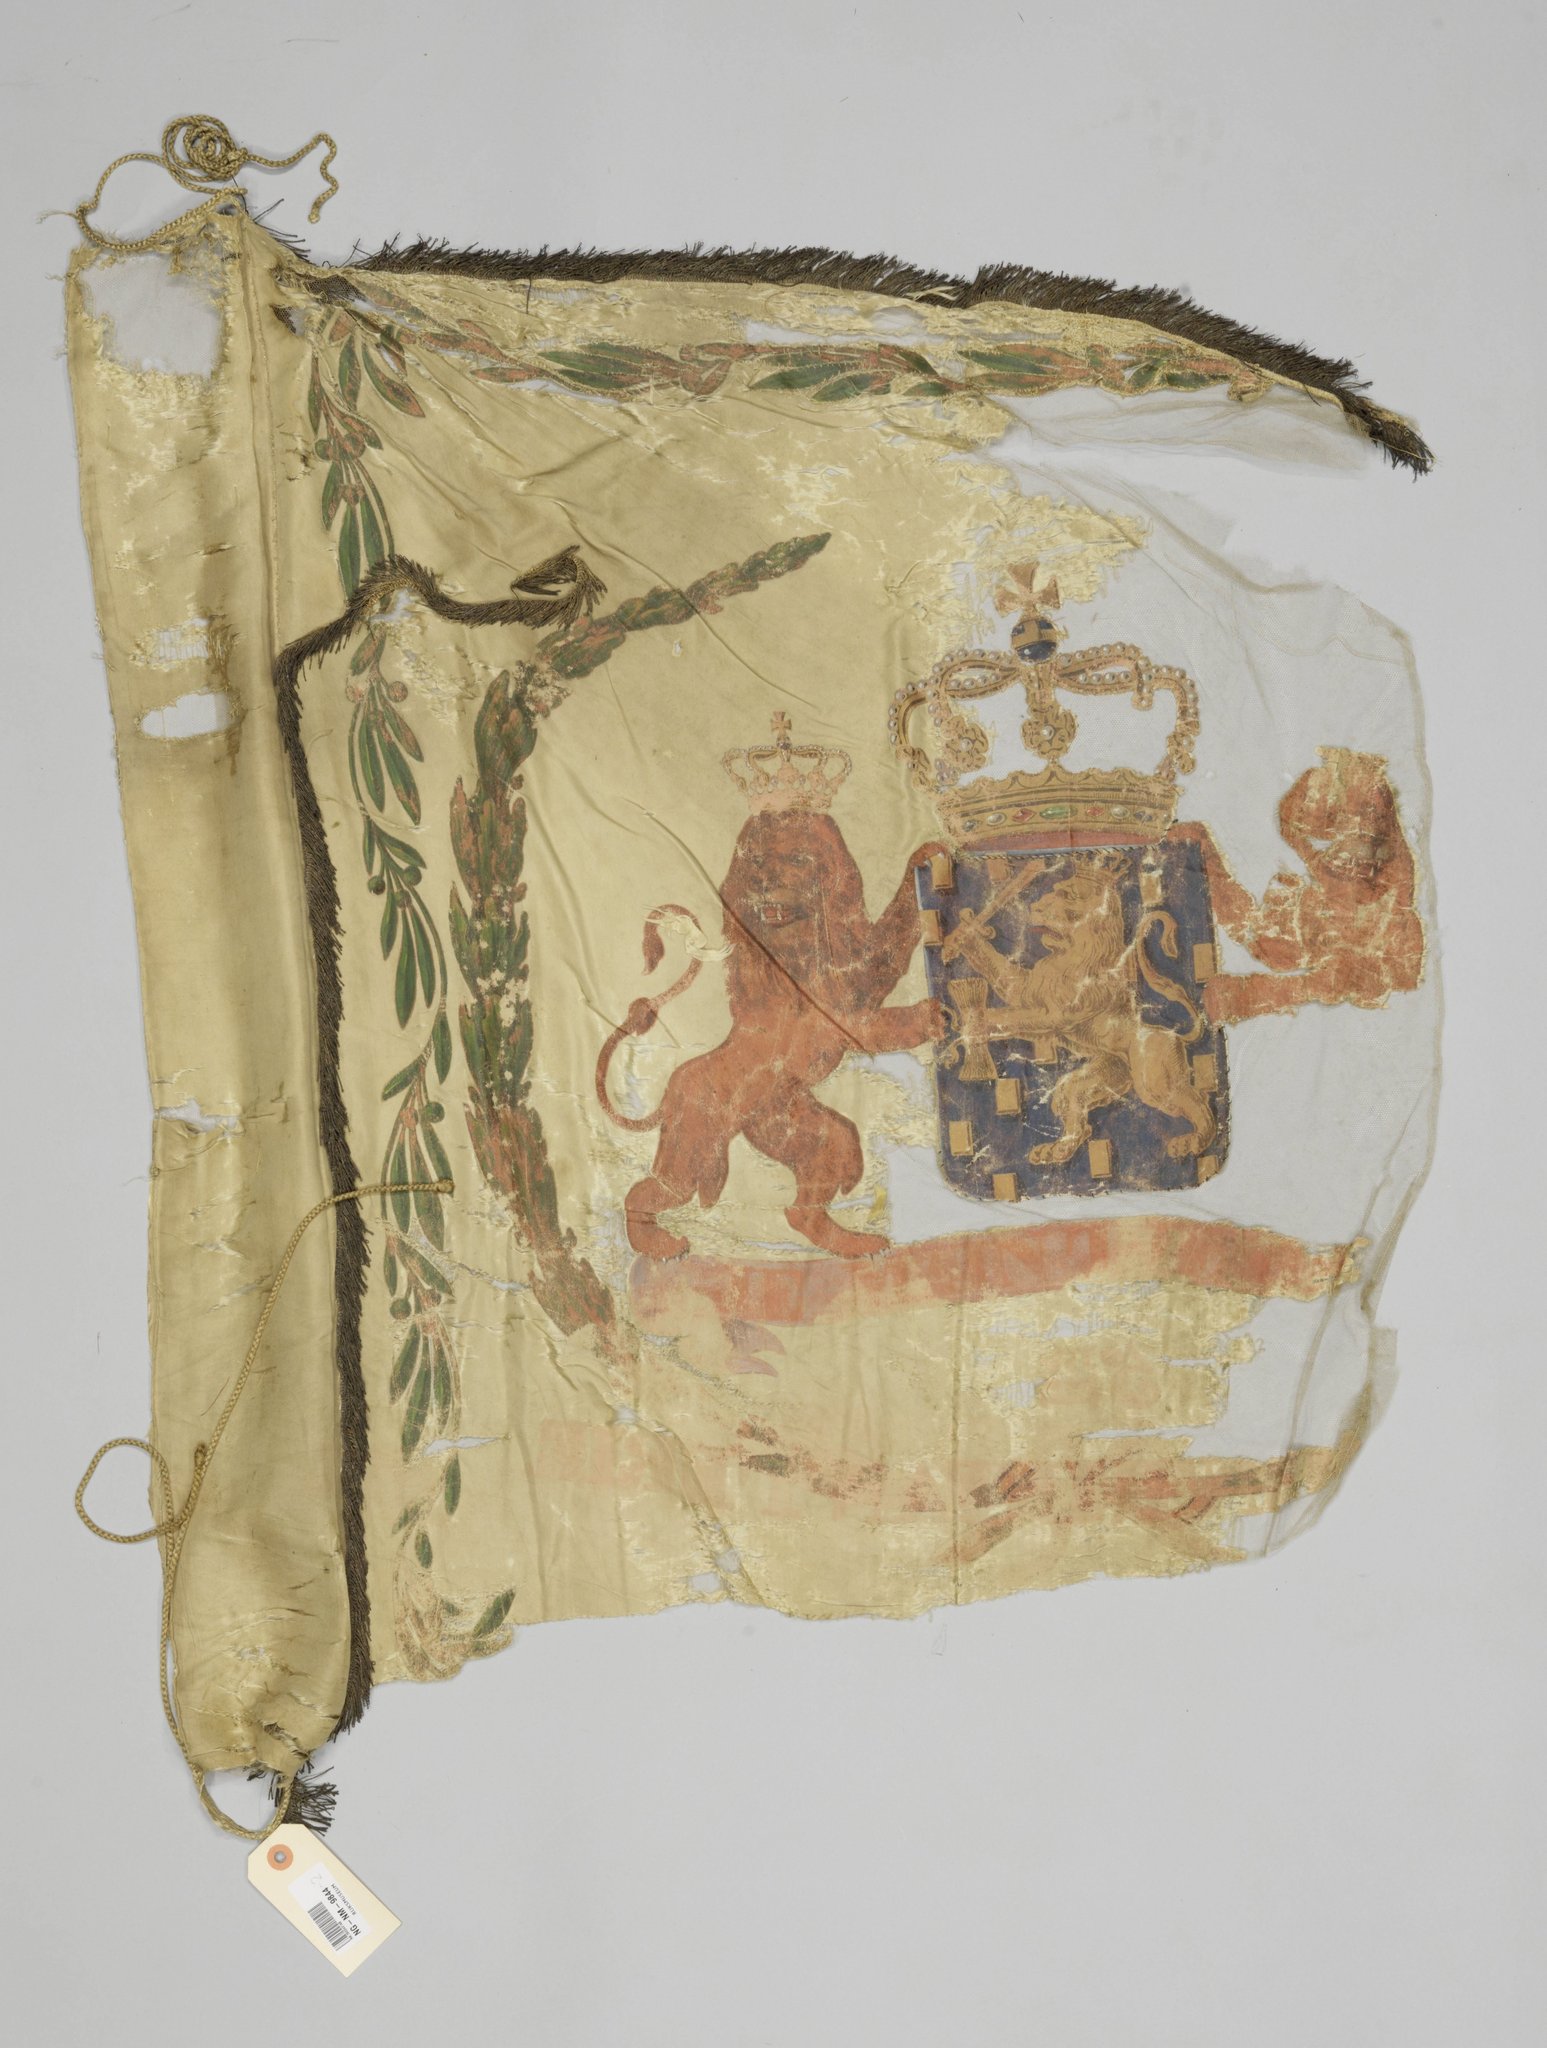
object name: banner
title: Vaandel van het vijfde afdeling infanterie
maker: jan willem pieneman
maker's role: draughtsman, painter, print maker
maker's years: 1779-1853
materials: bronze, silk, wood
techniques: painted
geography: netherlands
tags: netherlands